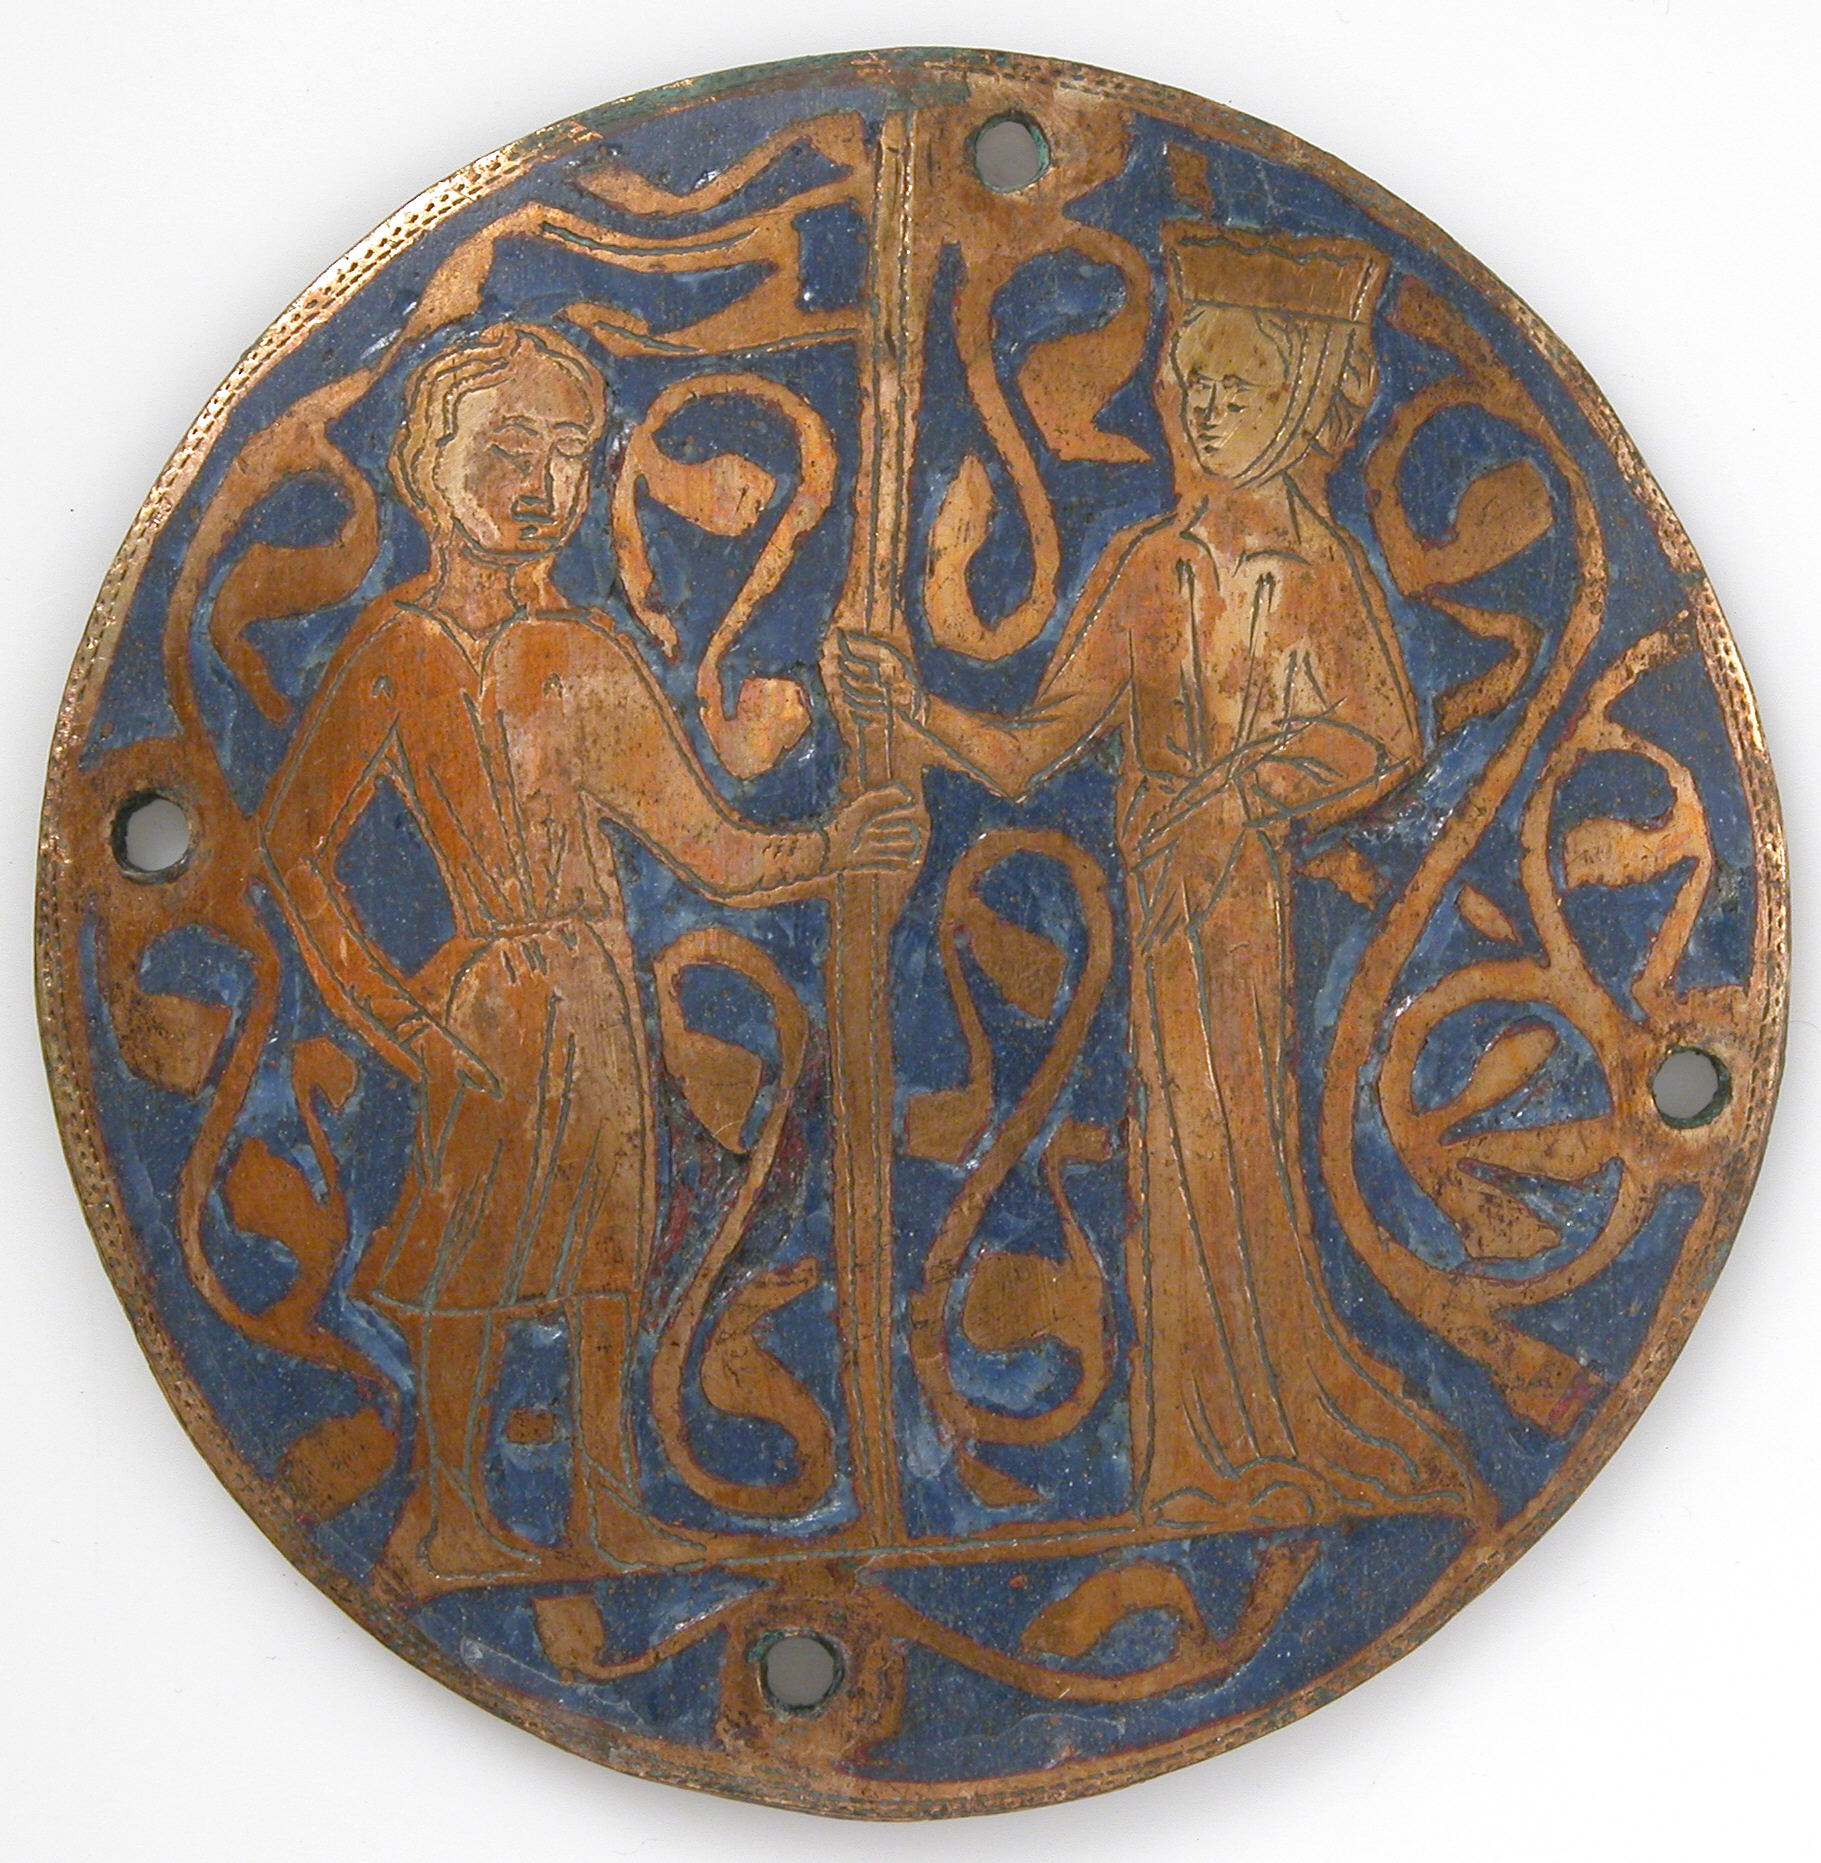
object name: medallion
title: Medallion with man and woman holding standard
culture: french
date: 1240-1260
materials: copper, enamel, gilt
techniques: enamel, engraving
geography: france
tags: men,women